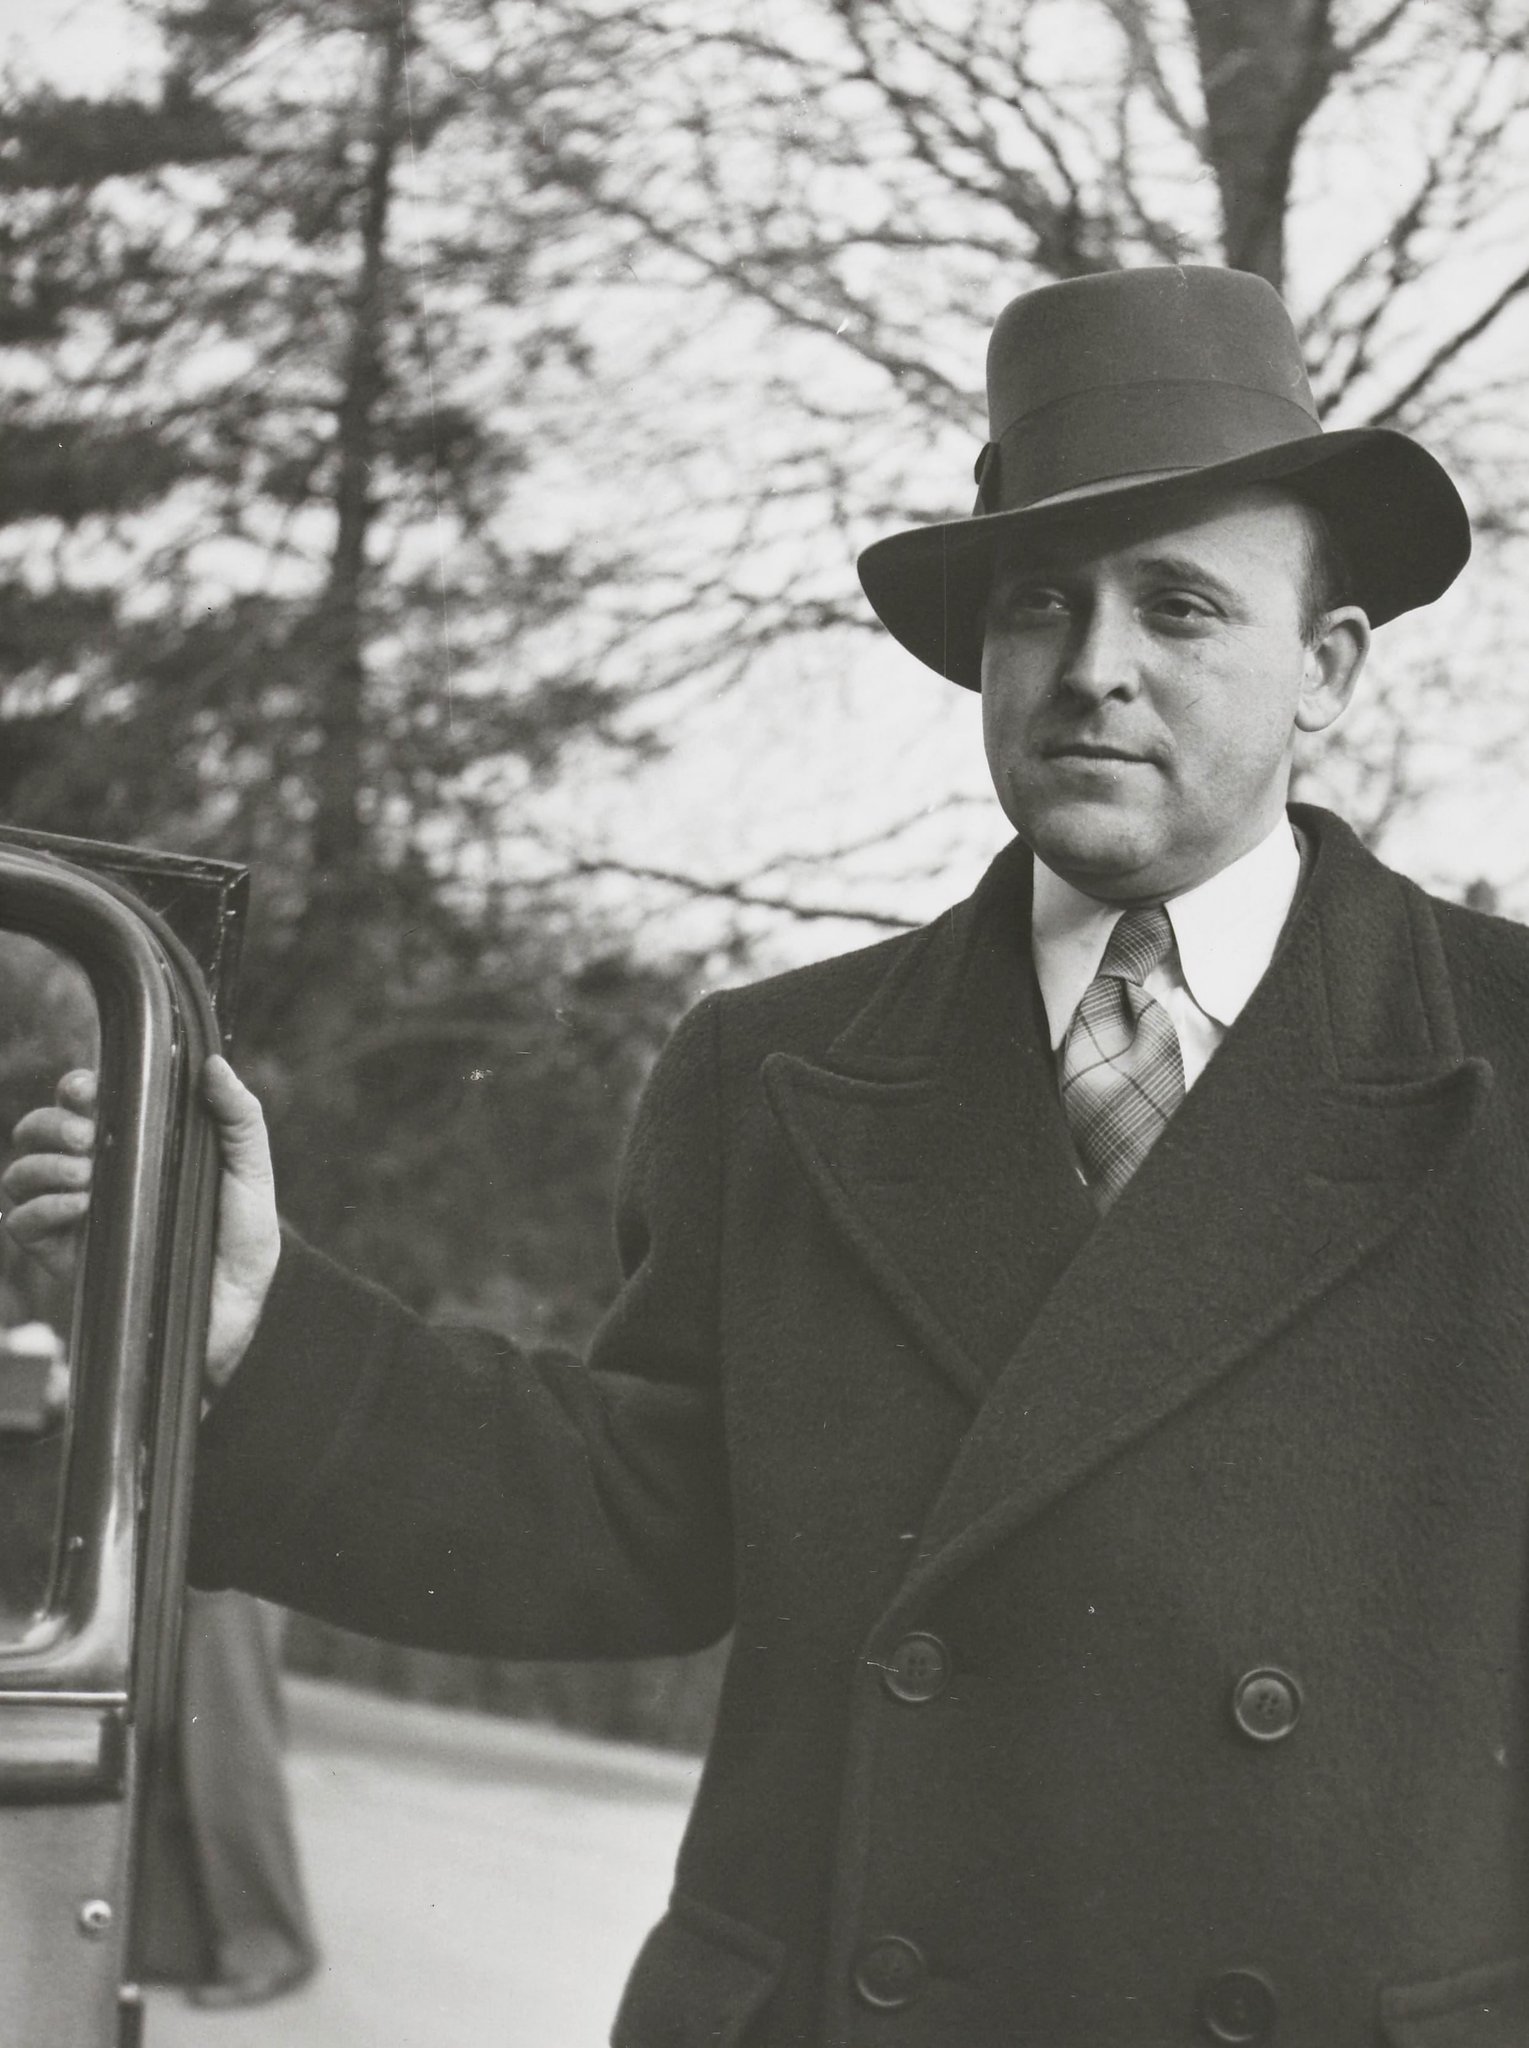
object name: documentary photograph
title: Surinamers in Nederland: 29 foto's uit het archief van Ons Vrije Nederland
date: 1902-1948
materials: photographic support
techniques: photography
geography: the hague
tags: netherlands, suriname, the hague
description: Een van de deelnemers namens Suriname aan de Ronde Tafel Conferentie tussen Nederland en de West: de jurist Mr. Dr. R.H. Pos, buiten gefotografeerd bij een auto. Hij is oud Advocaat-Generaal van Suriname en was permanent vertegenwoordiger van Suriname in Nederland.